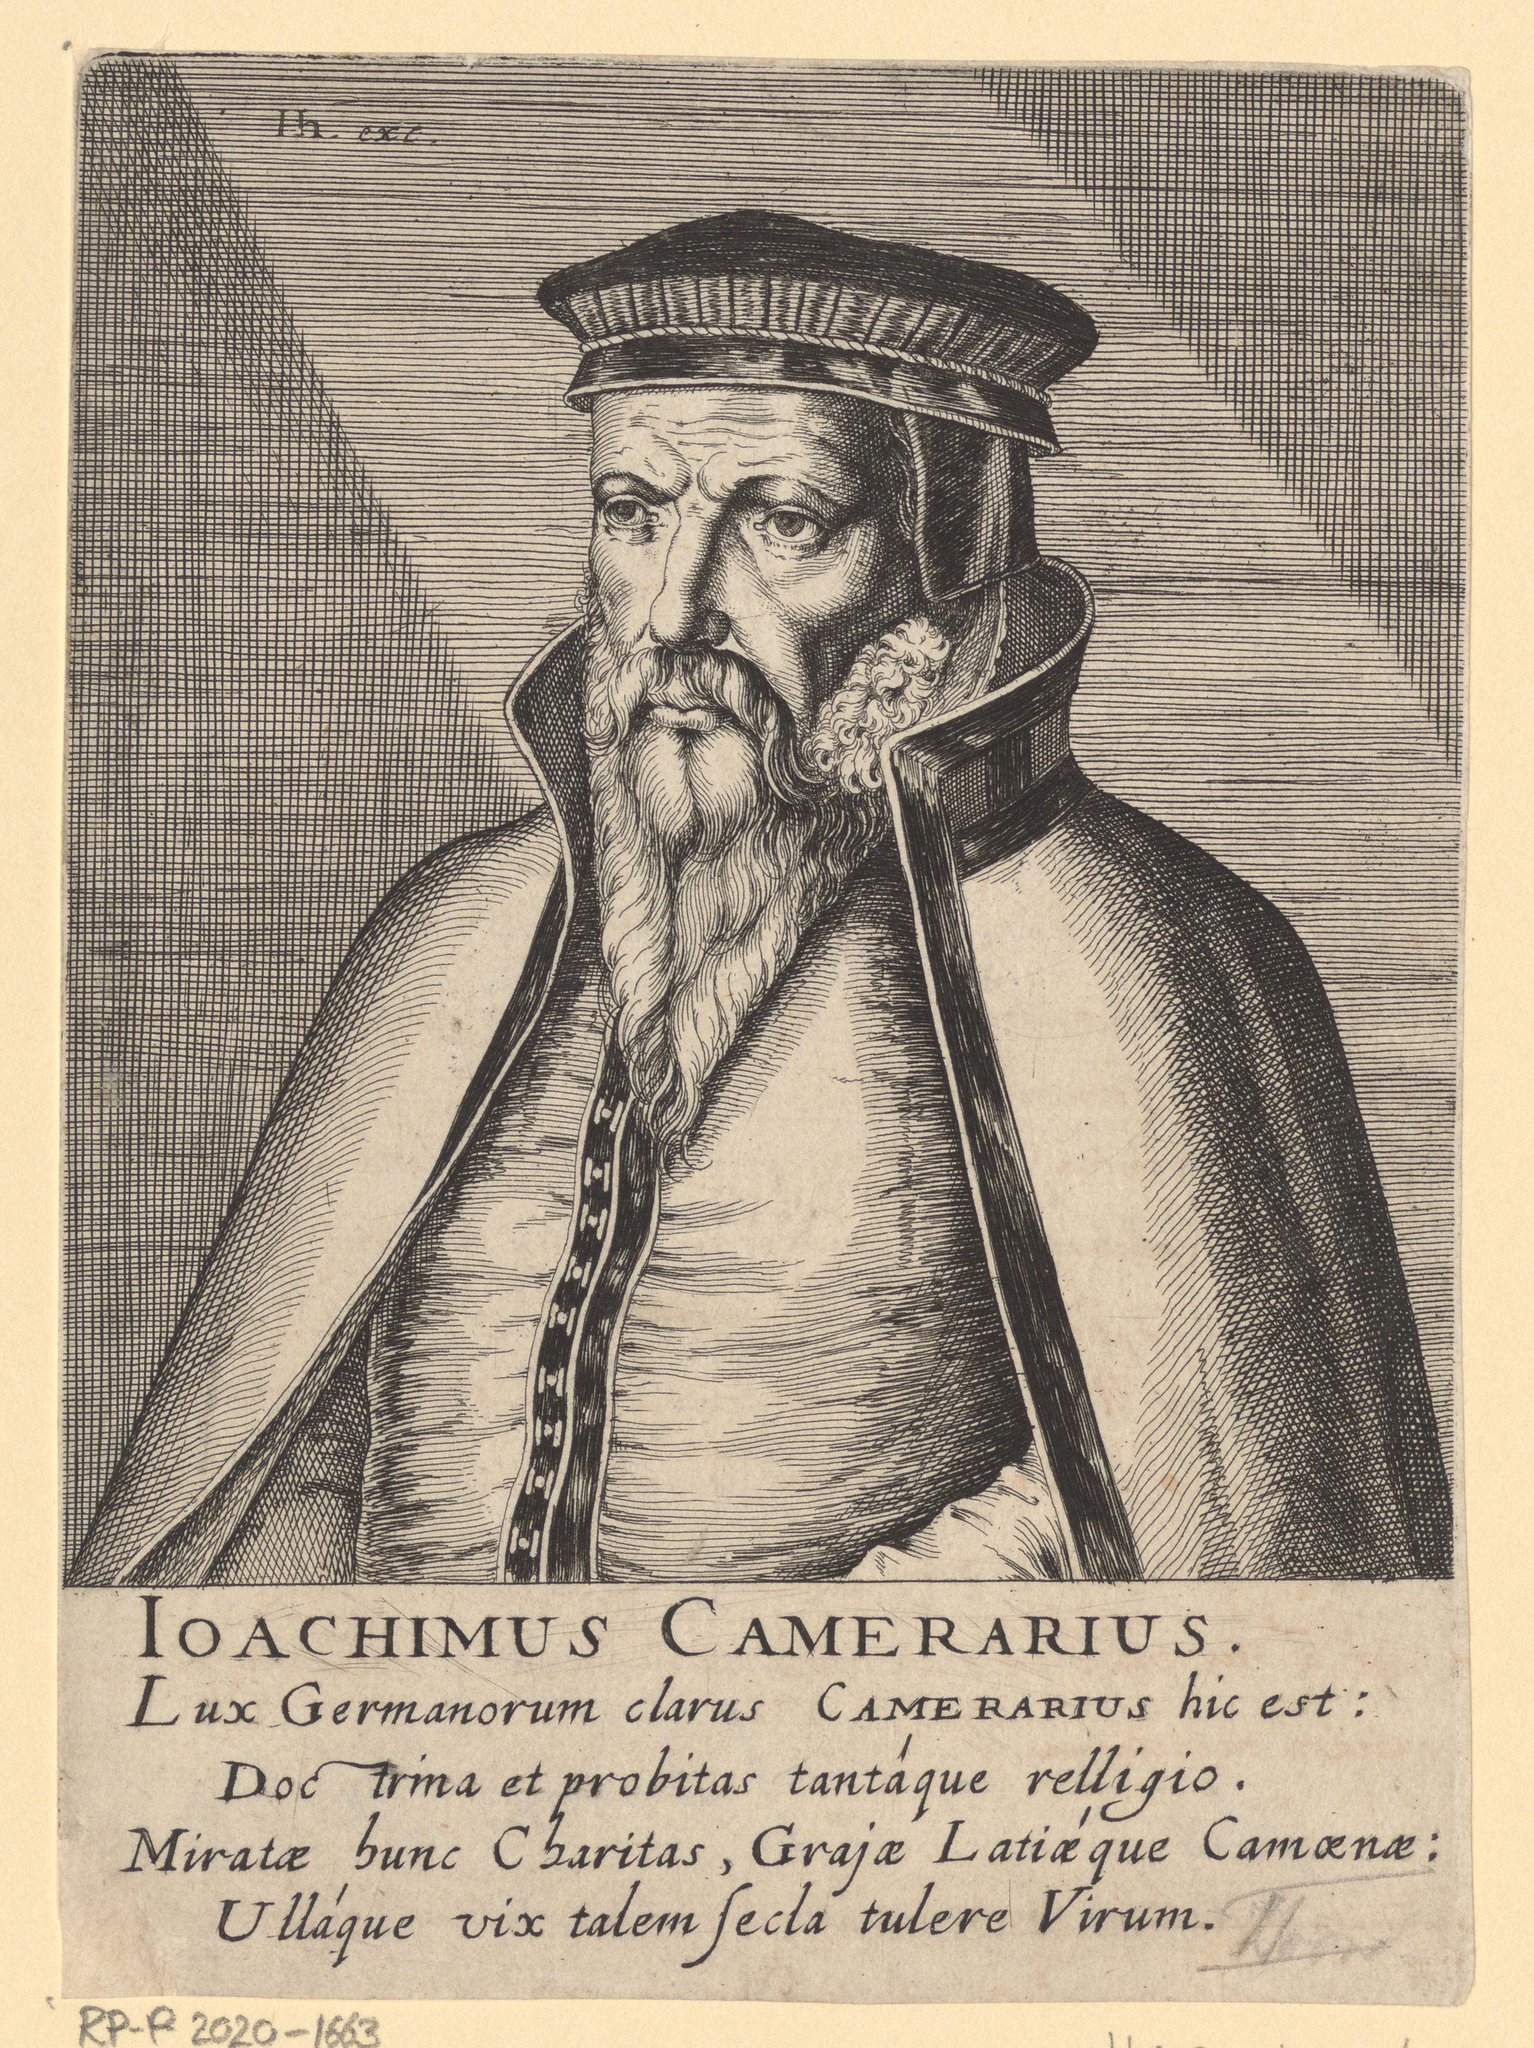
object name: print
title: Effigies præstant. aliquot virorum qui veram in primis religion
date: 1610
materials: ink, paper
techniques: engraving, etching, pen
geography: the hague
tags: joachim camerarius (i), historical persons